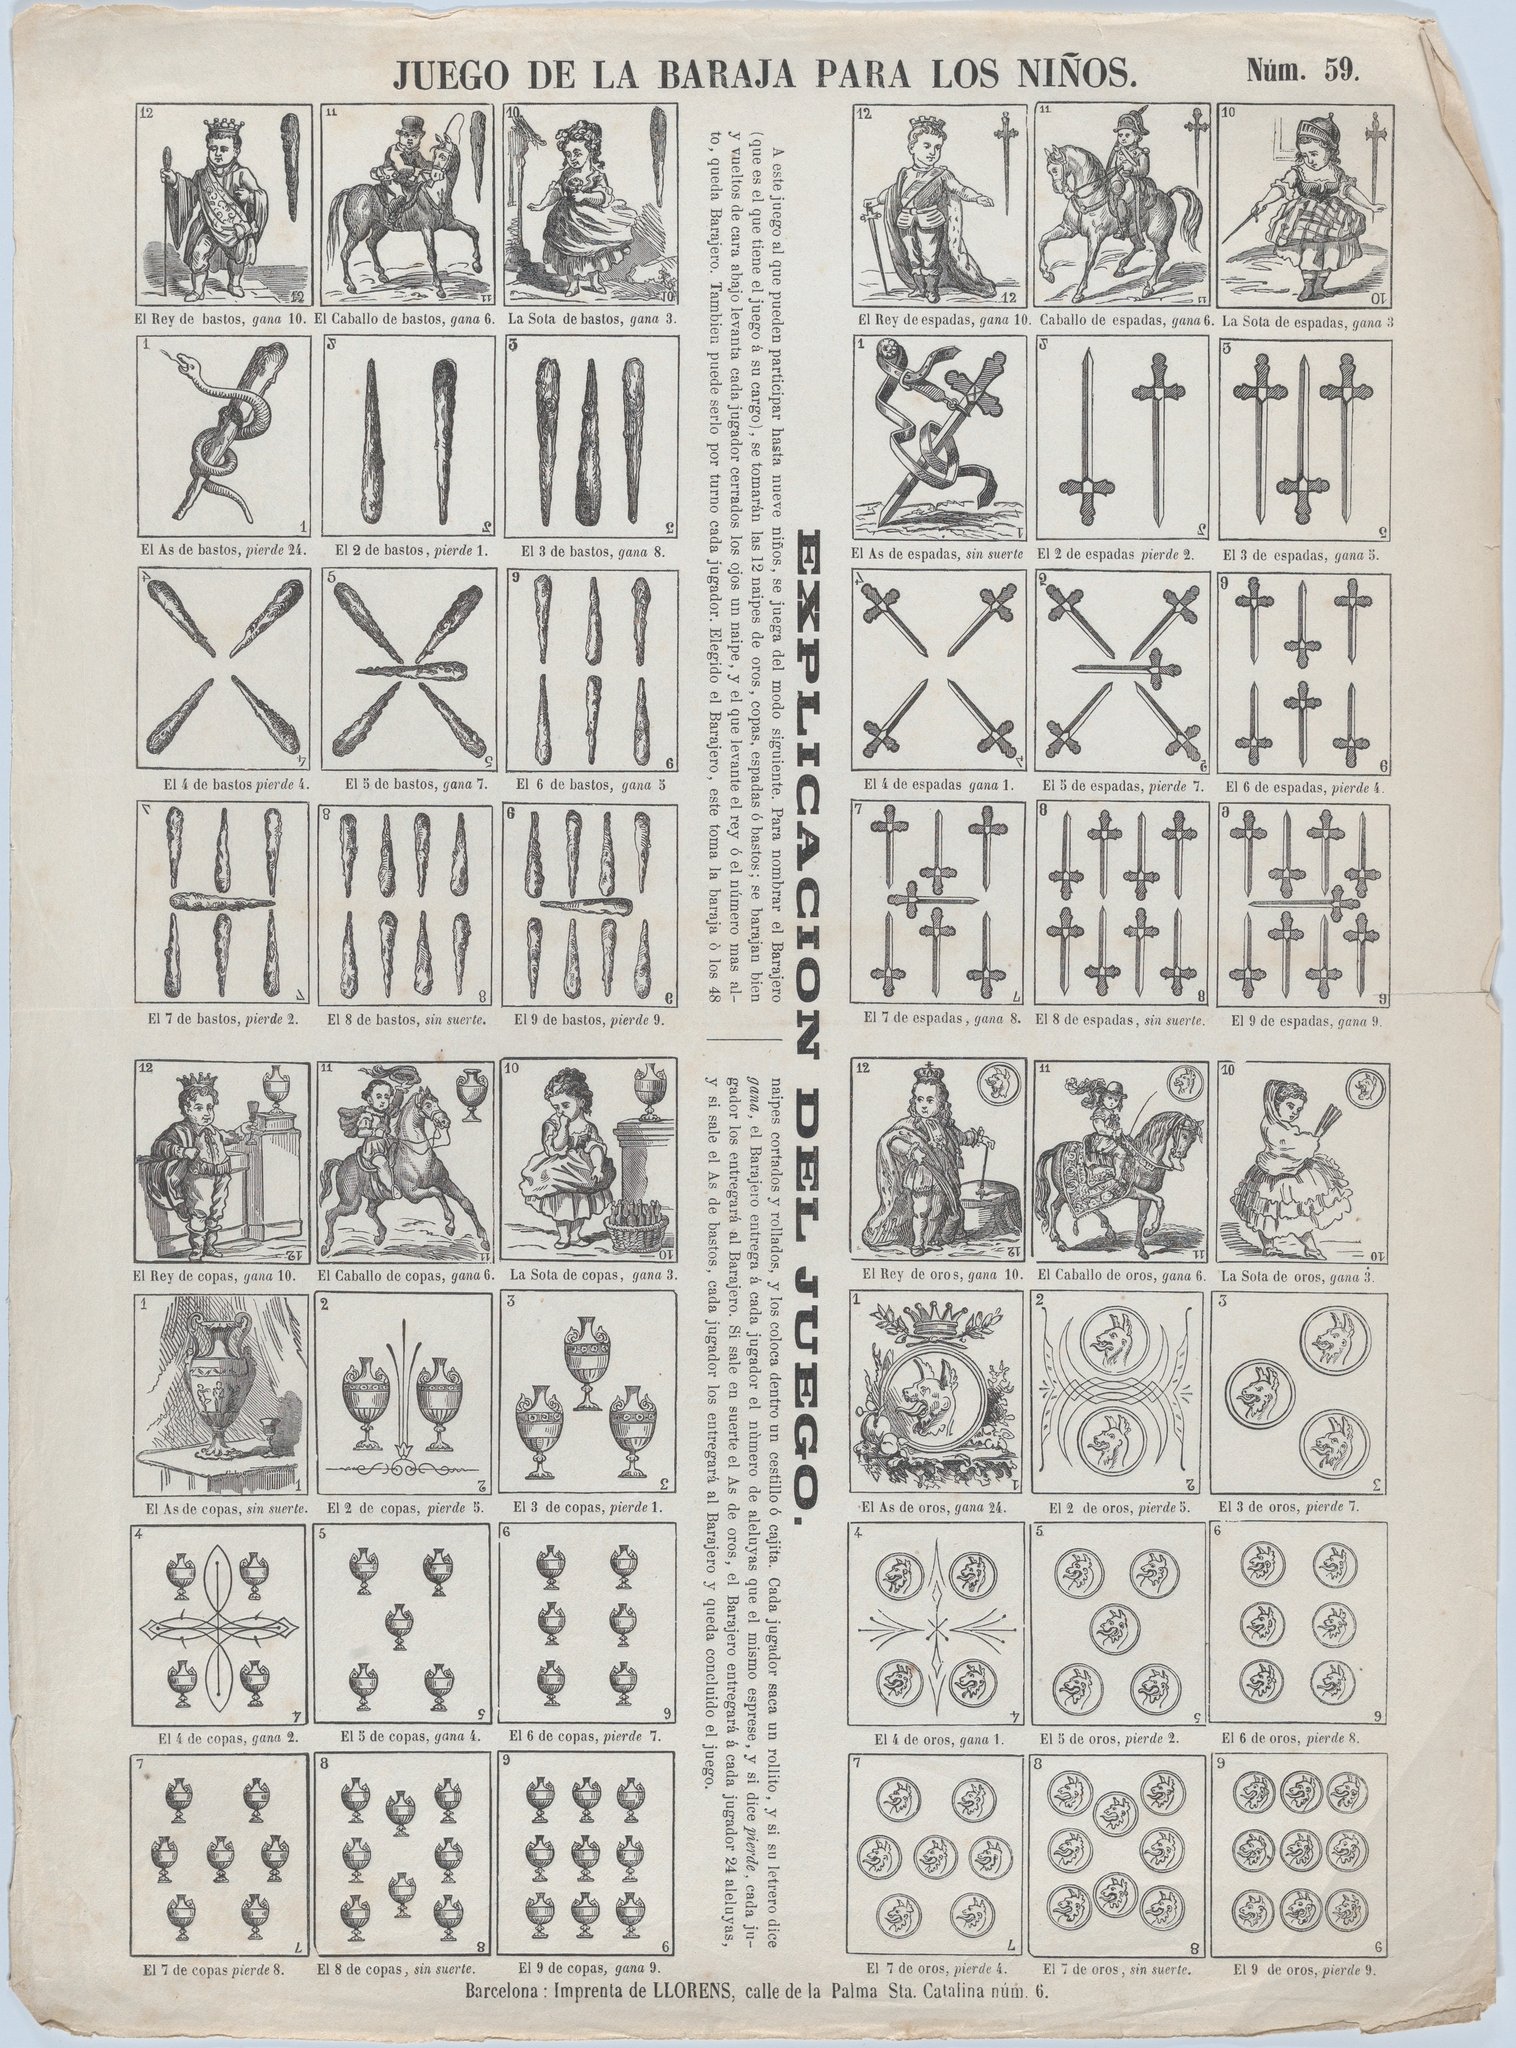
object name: print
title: Sheet of playing cards for children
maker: juan llorens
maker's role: publisher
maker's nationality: spanish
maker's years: 1800-1900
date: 1860-1870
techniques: letterpress, engraving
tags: playing cards